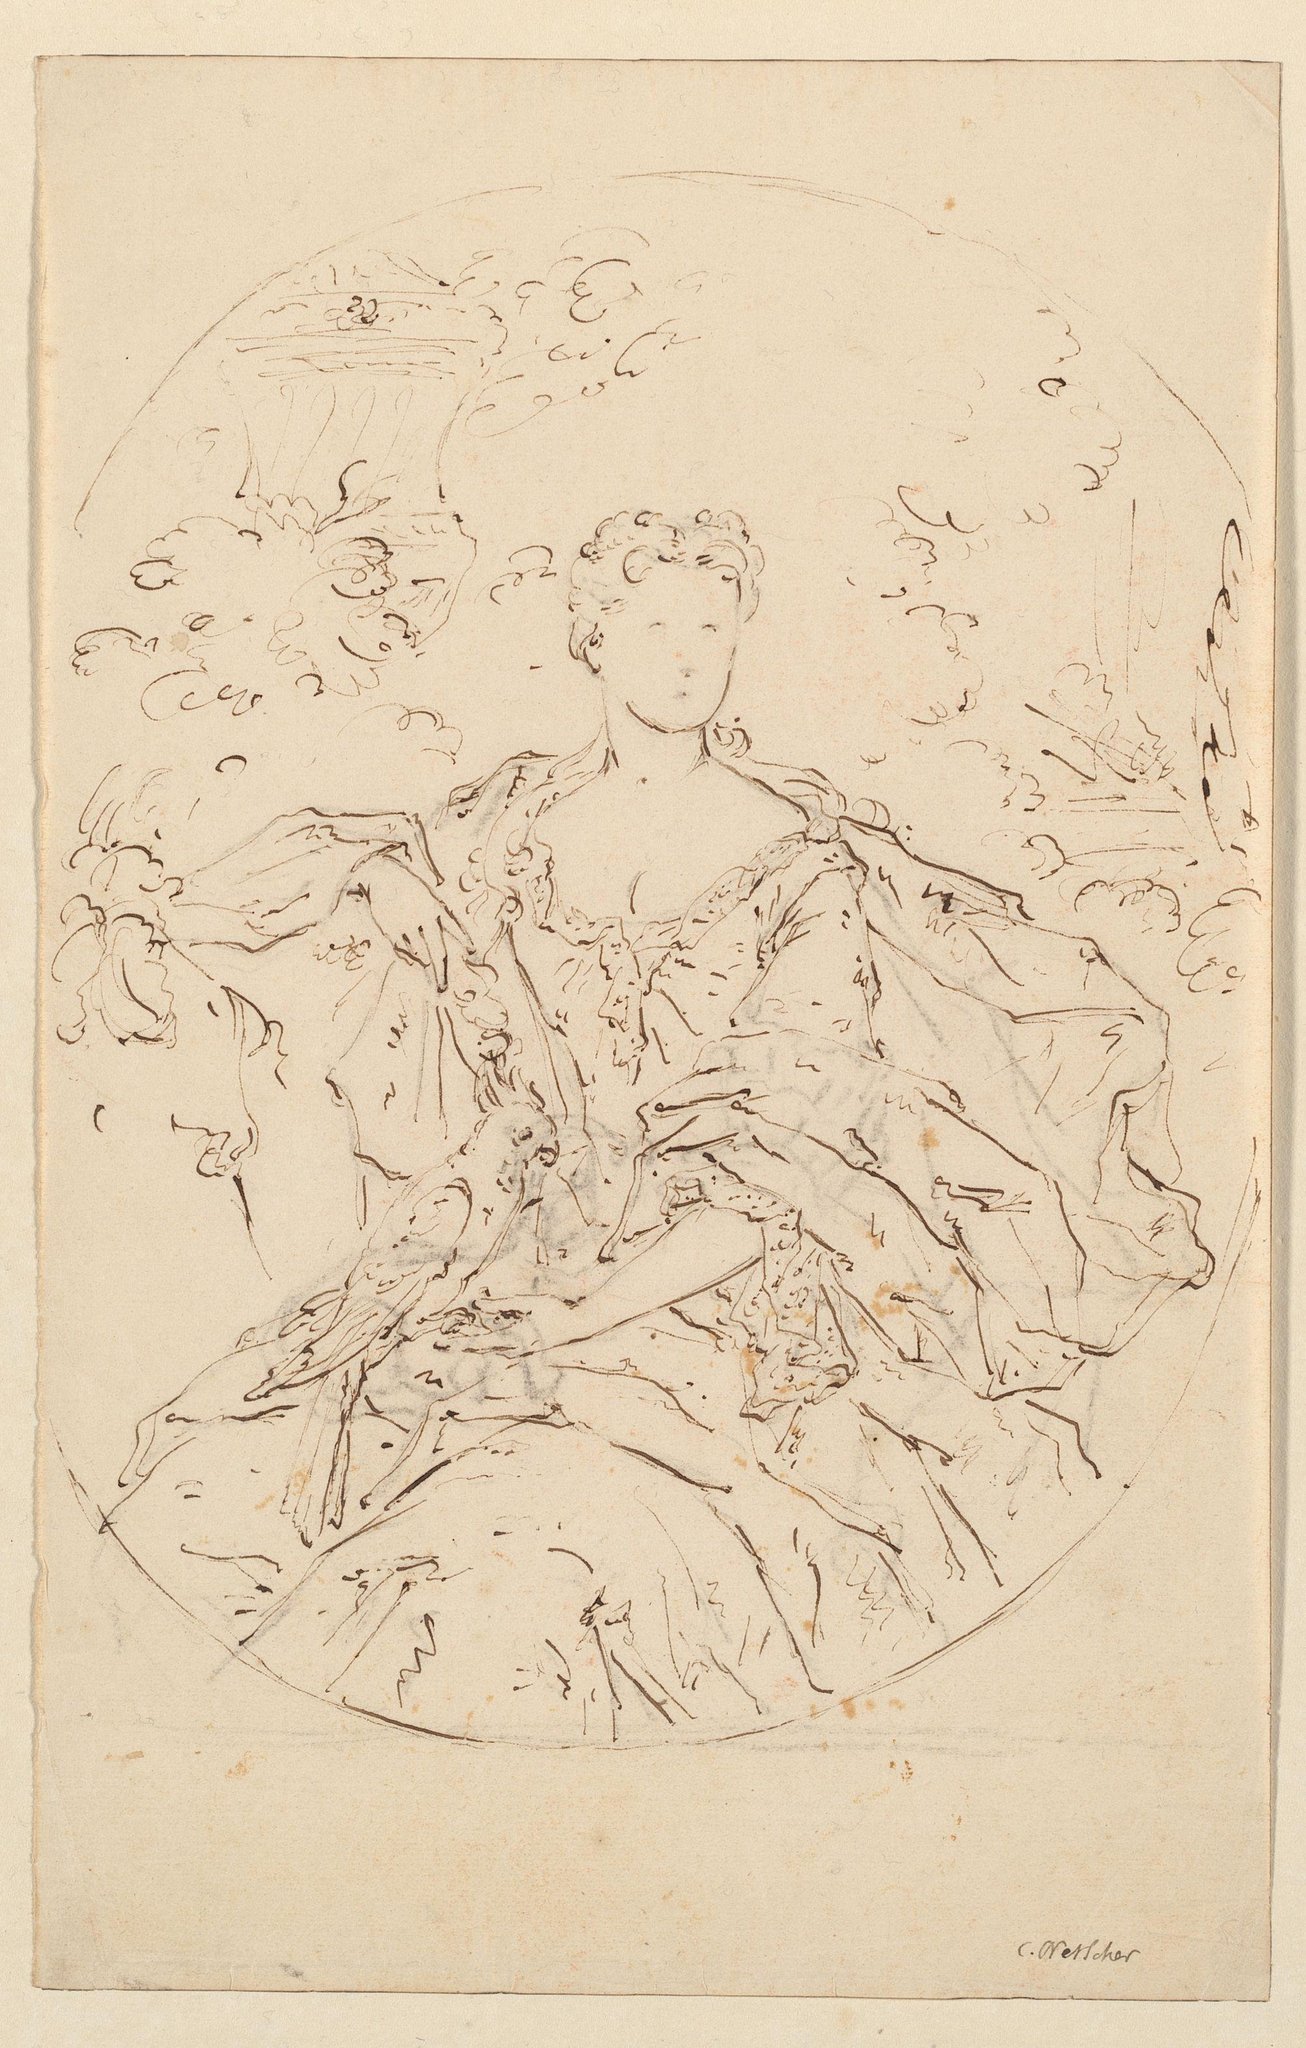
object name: album leaf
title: Portret van een vrouw met kaketoe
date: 1649-1723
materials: chalk, ink, paper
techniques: pen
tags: historical persons not known by name - bb - woman, ornamental birds: cockatoo